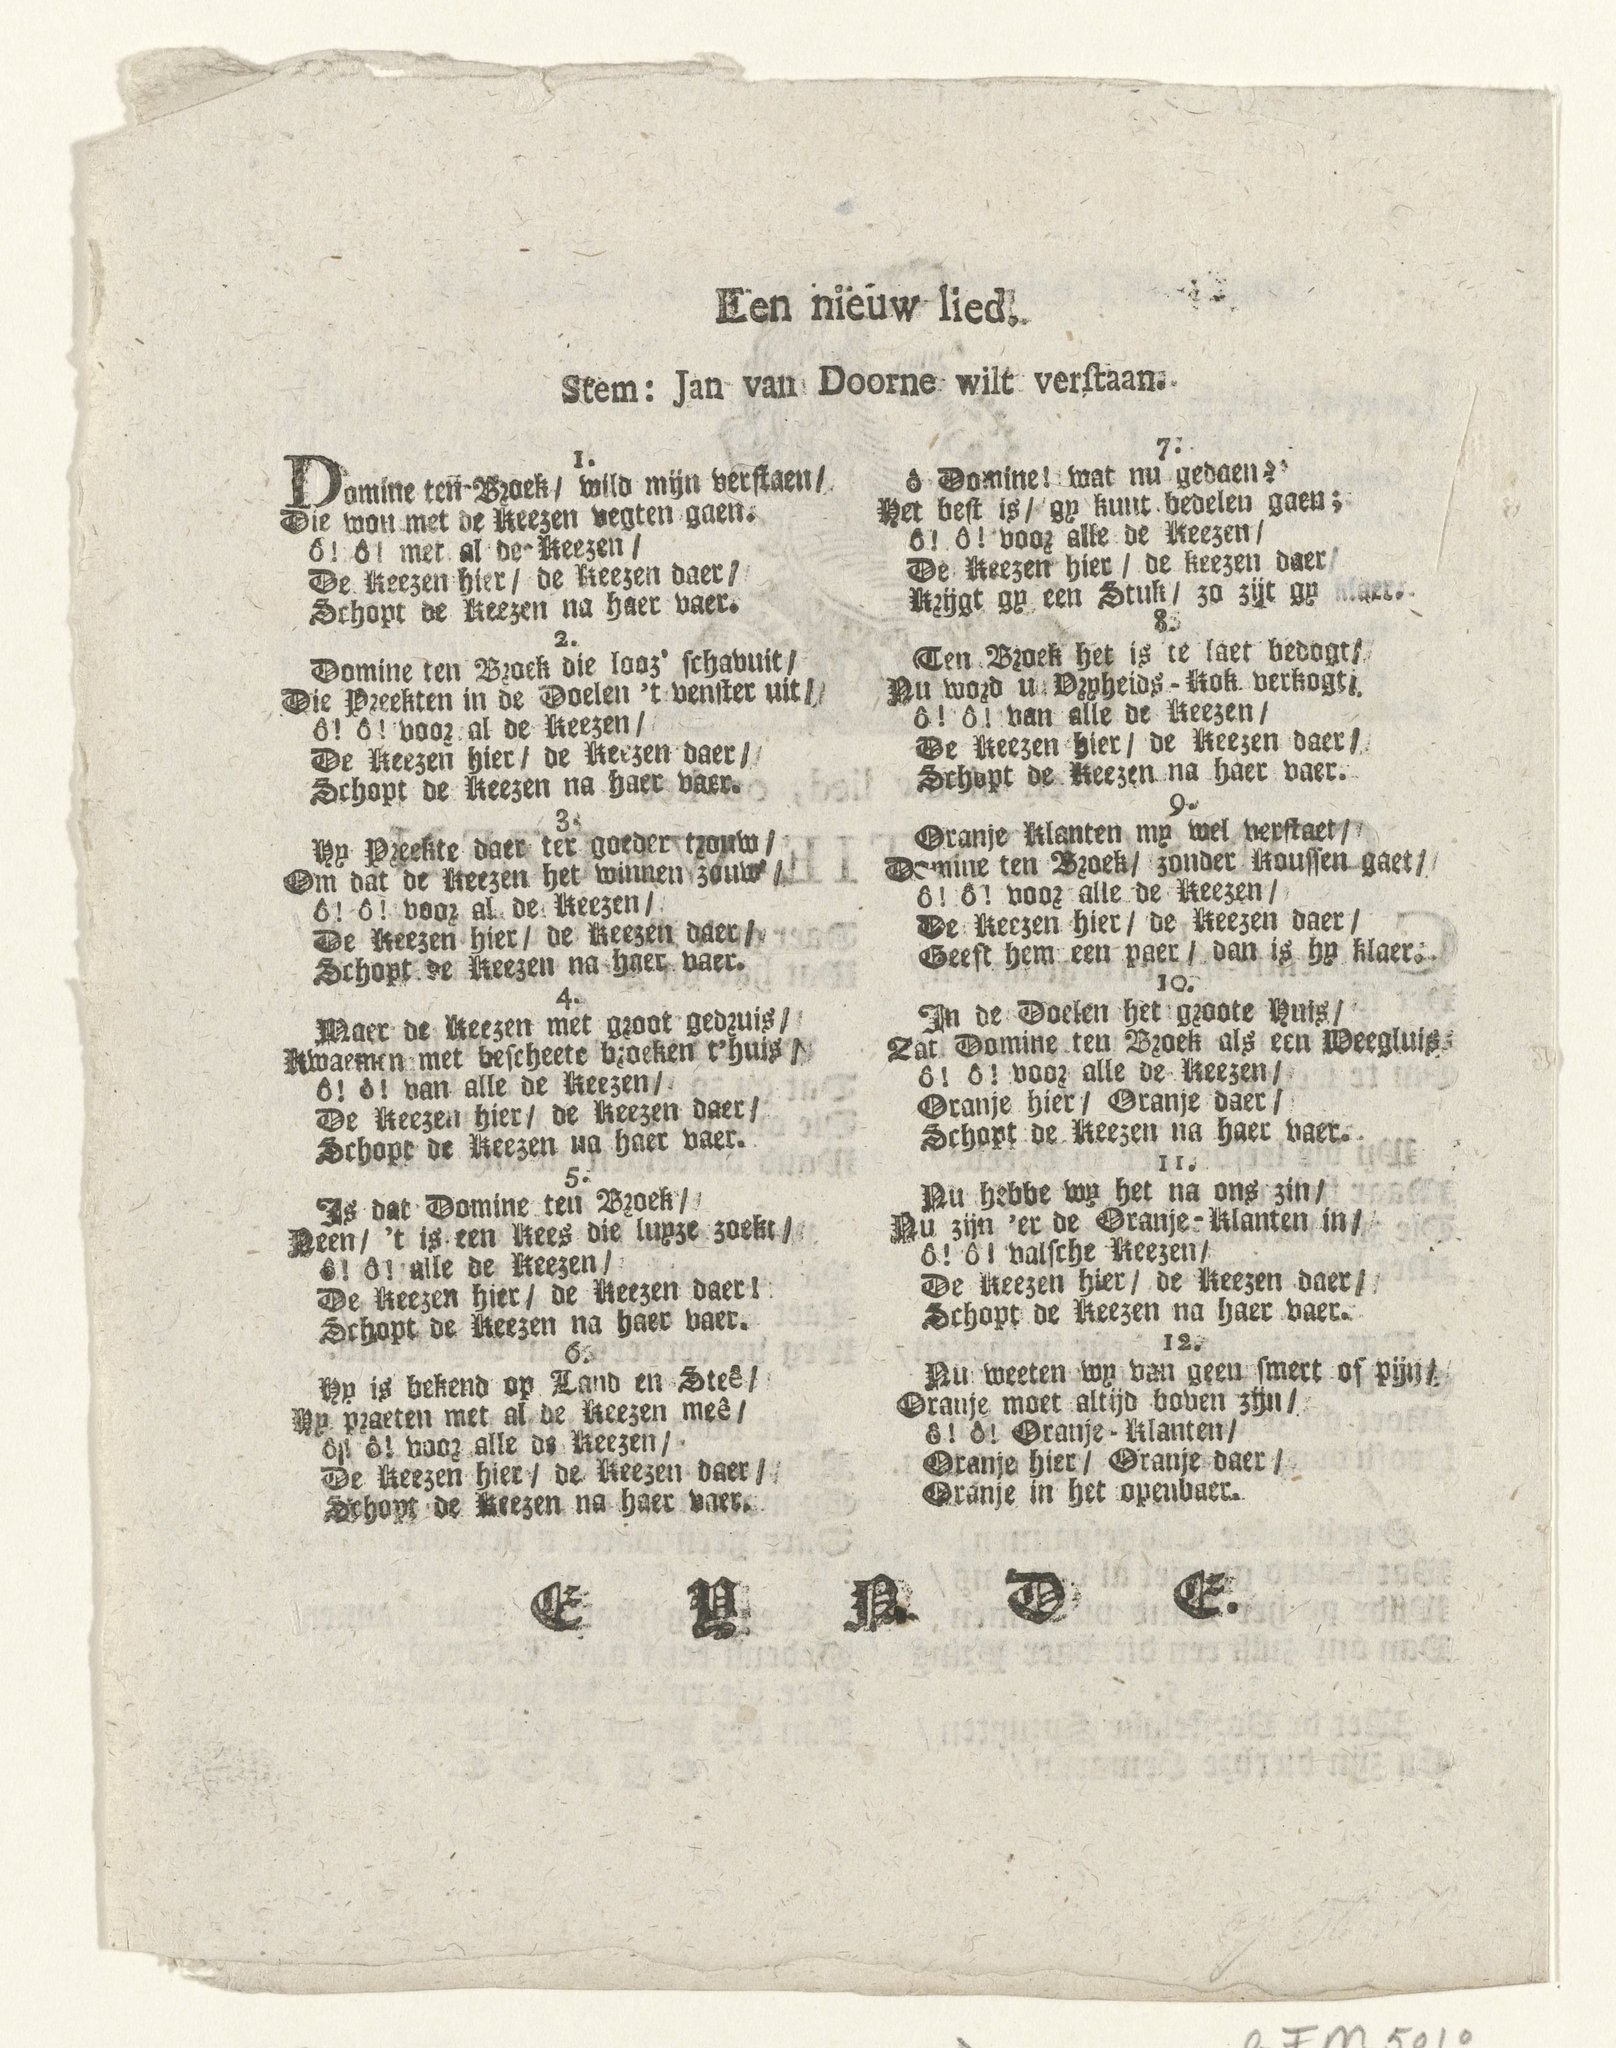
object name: text sheet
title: Liederen op de patriotten, 1787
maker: Anonymous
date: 1787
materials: paper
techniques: letterpress printing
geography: northern netherlands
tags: herstel van stadhouder willem v (1787)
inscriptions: collector's mark: Lugt 2228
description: Blad met vijf spotliederen op de patriotten, na het herstel van de prins van Oranje in 1787. Dubbelgevouwen blad met de tekst van vijf verschillende liedjes, bij één lied een vignet met een man met een grote neus.